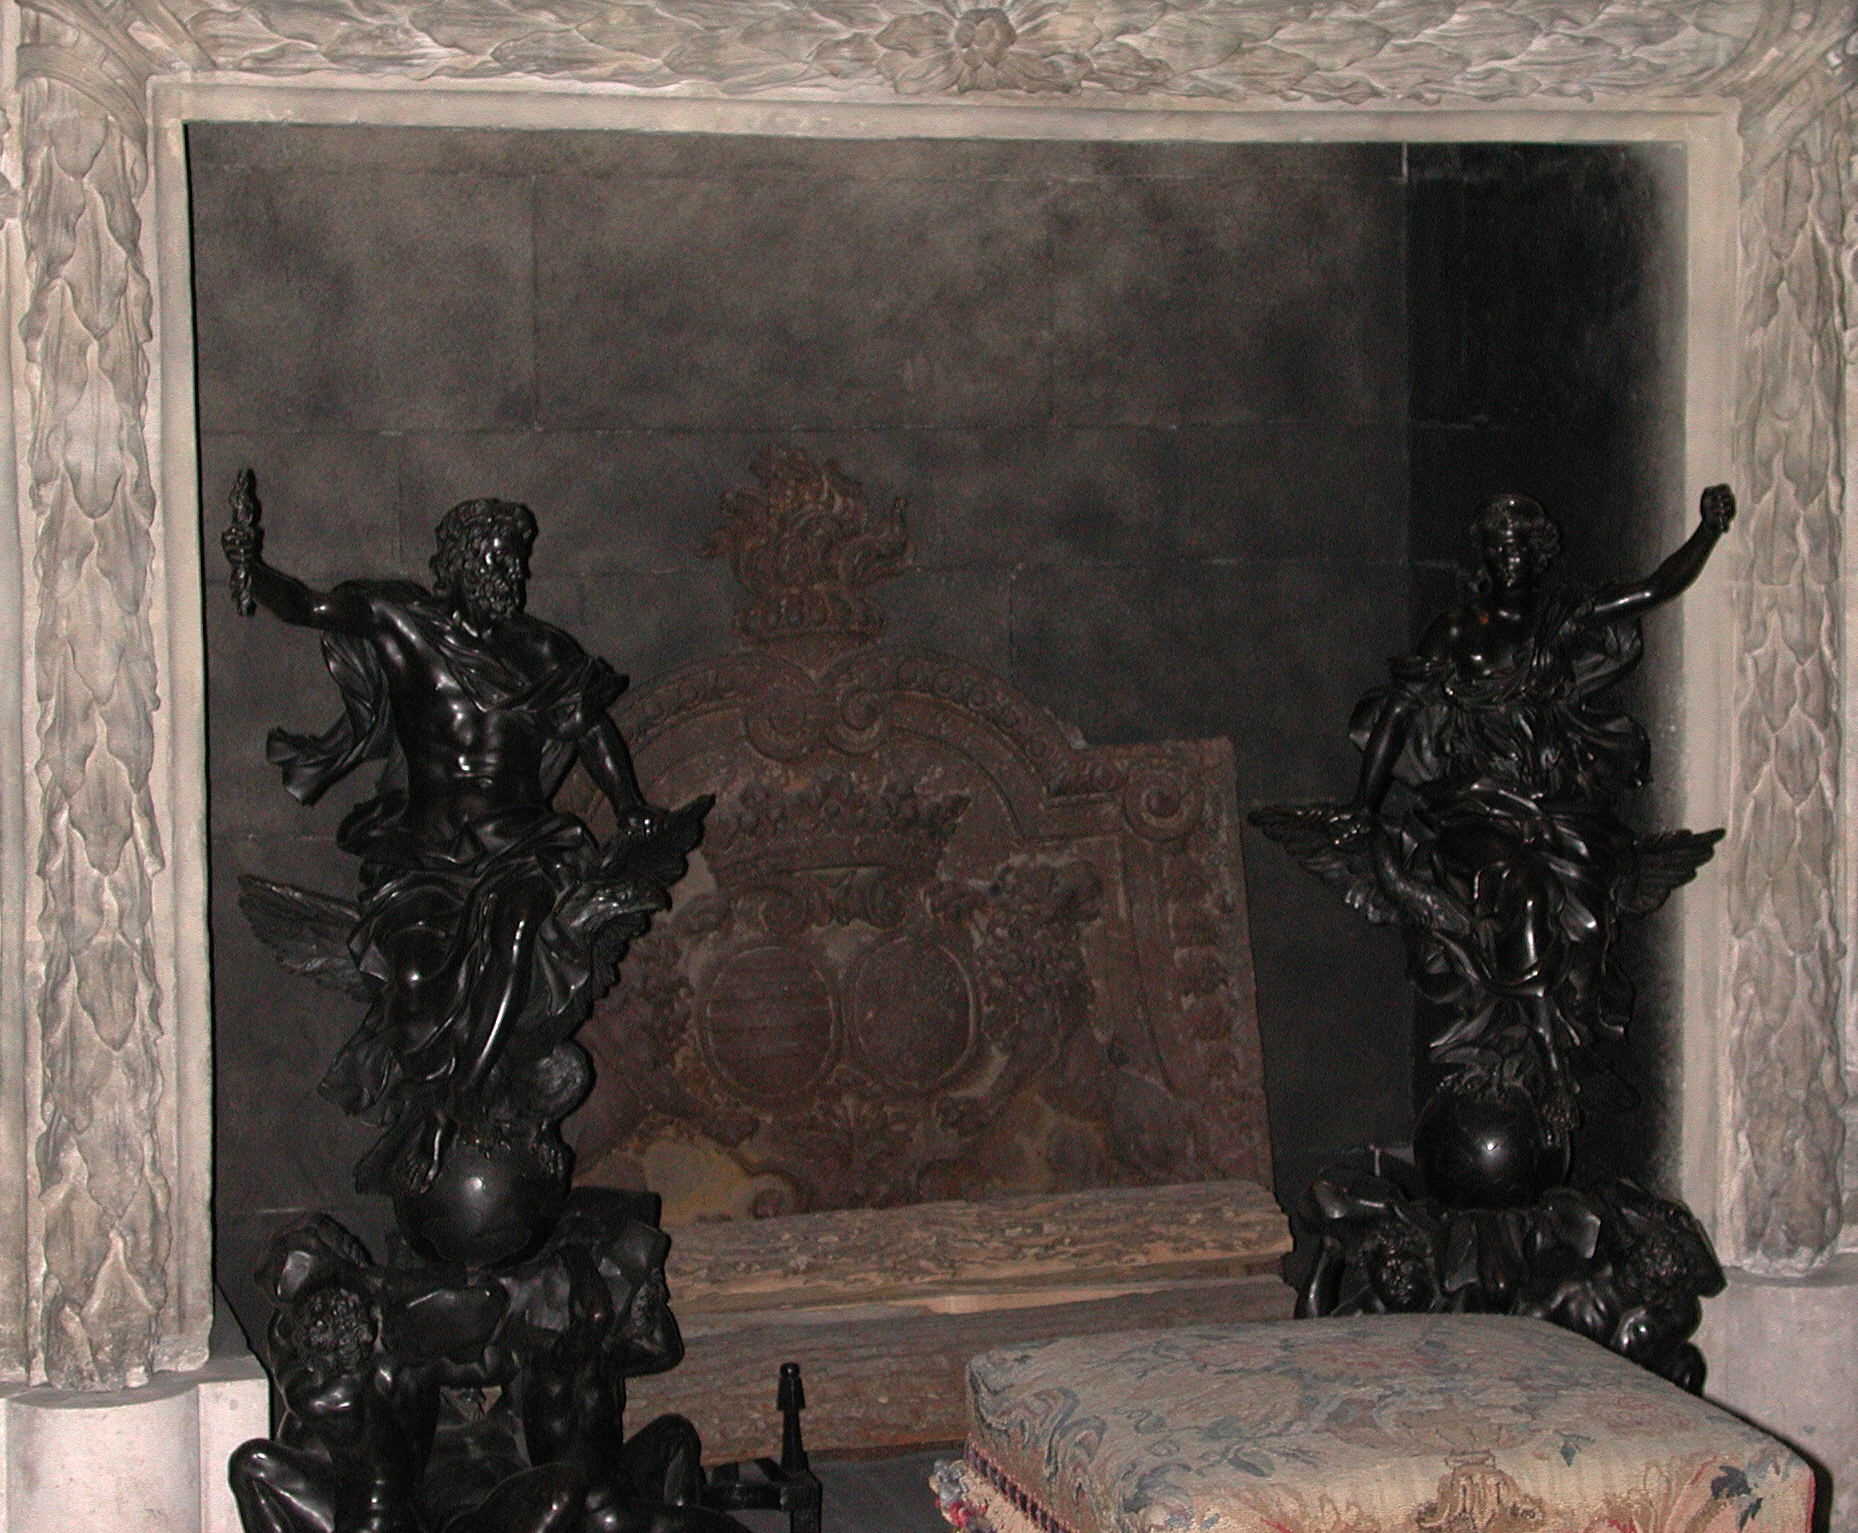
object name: fireback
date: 1676-1700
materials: iron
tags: coat of arms